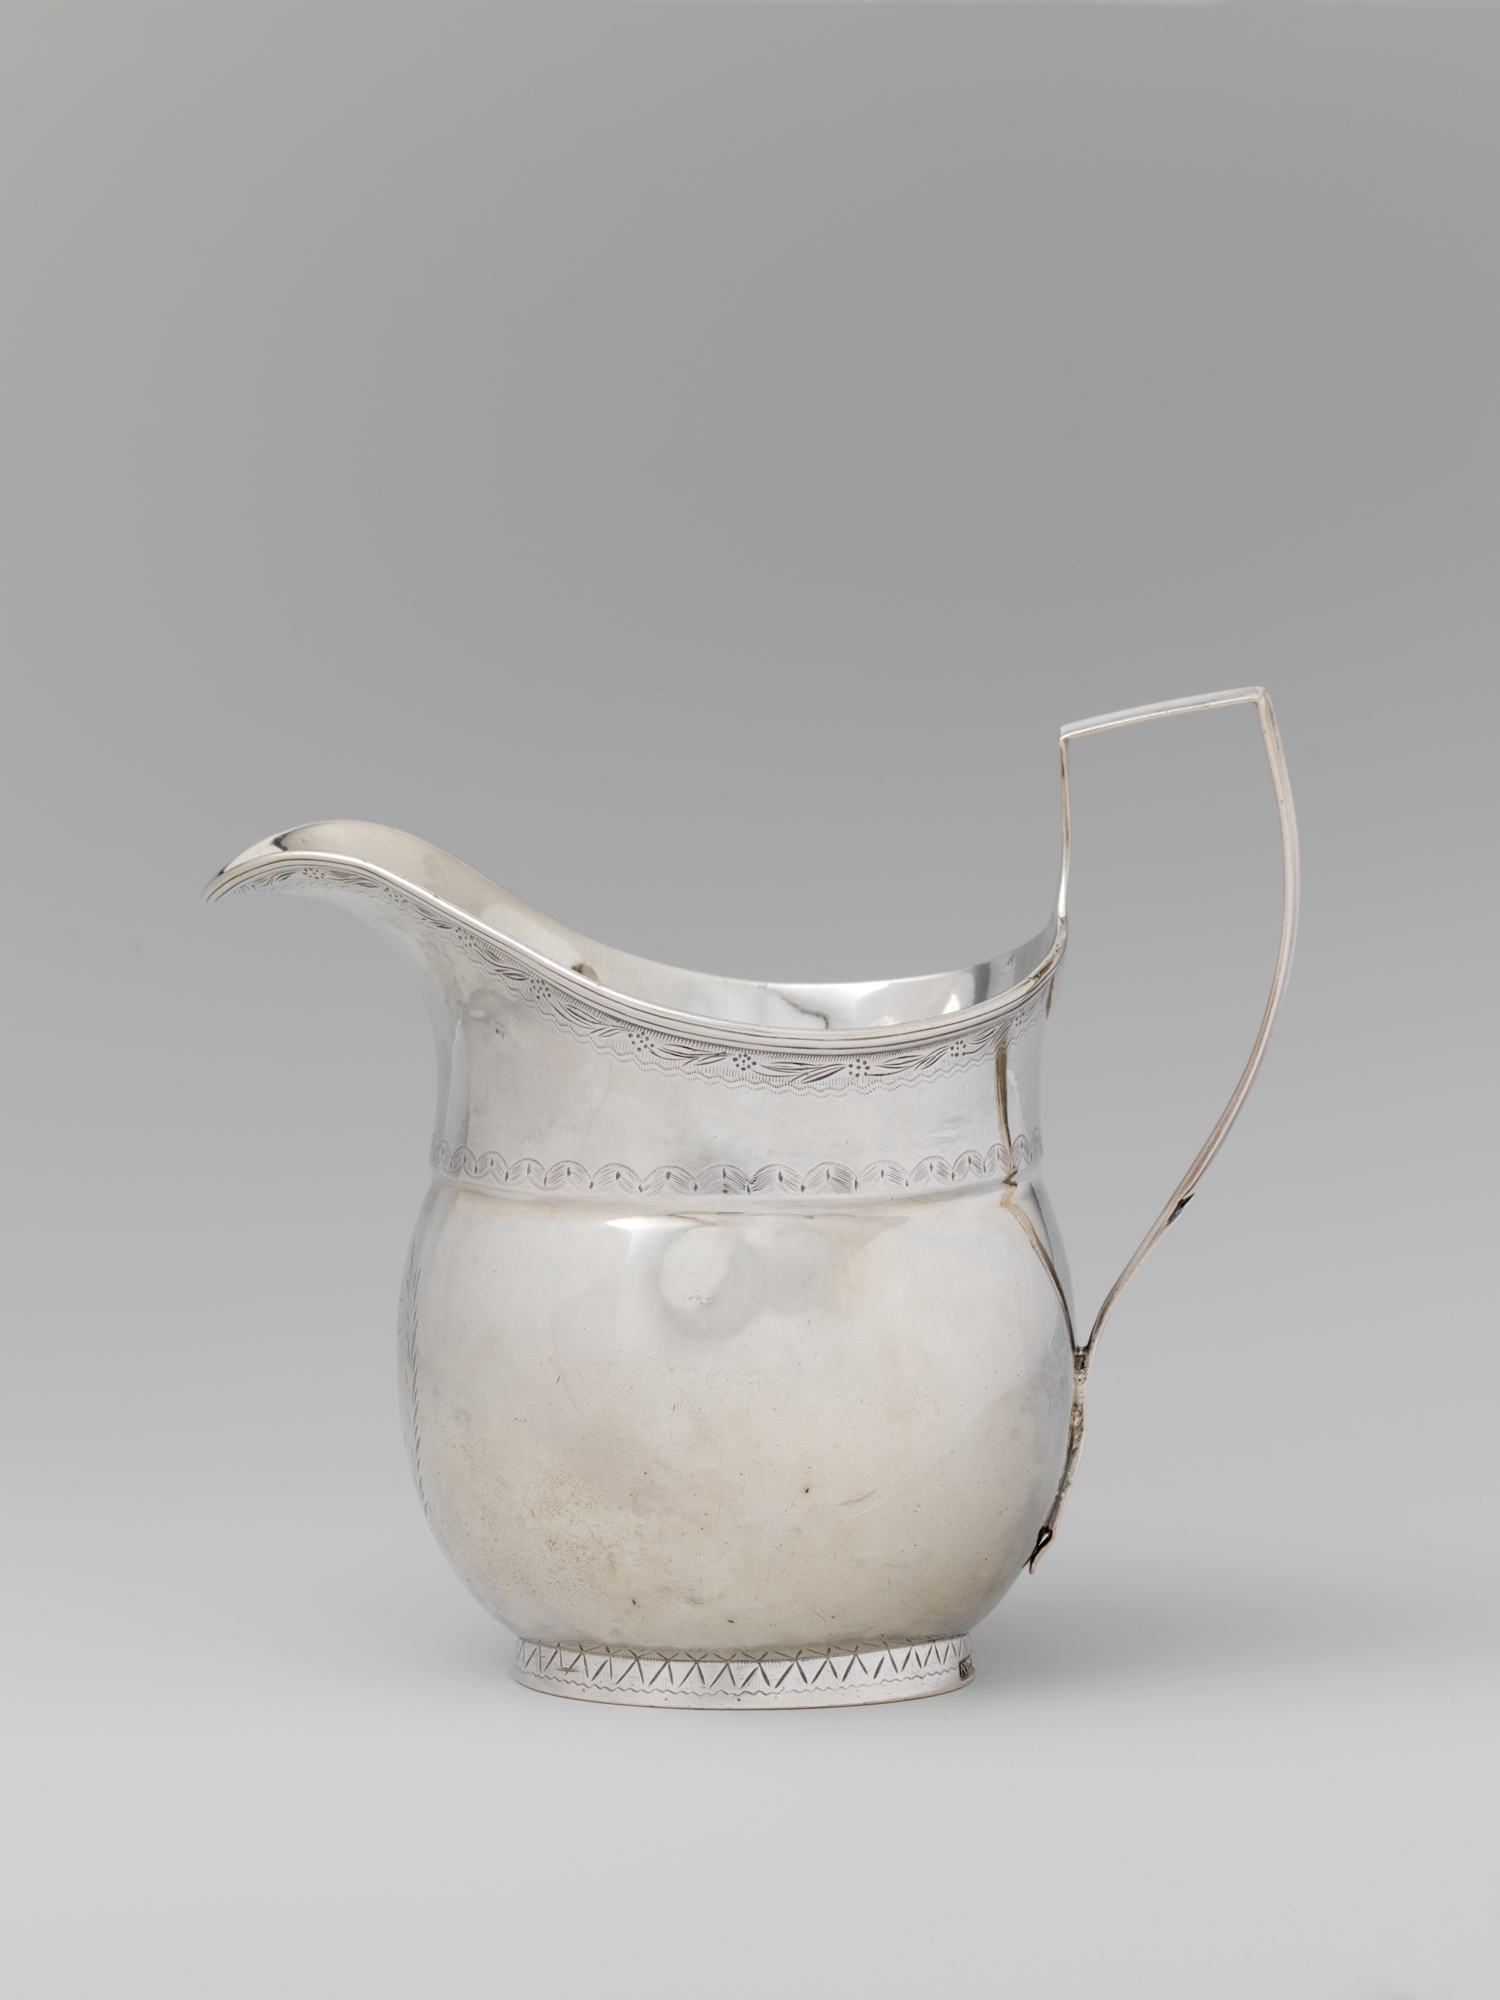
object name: cream pot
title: Creamer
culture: american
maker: saunders pitman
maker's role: maker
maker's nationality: american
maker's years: 1732-1804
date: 1800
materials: silver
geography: united states